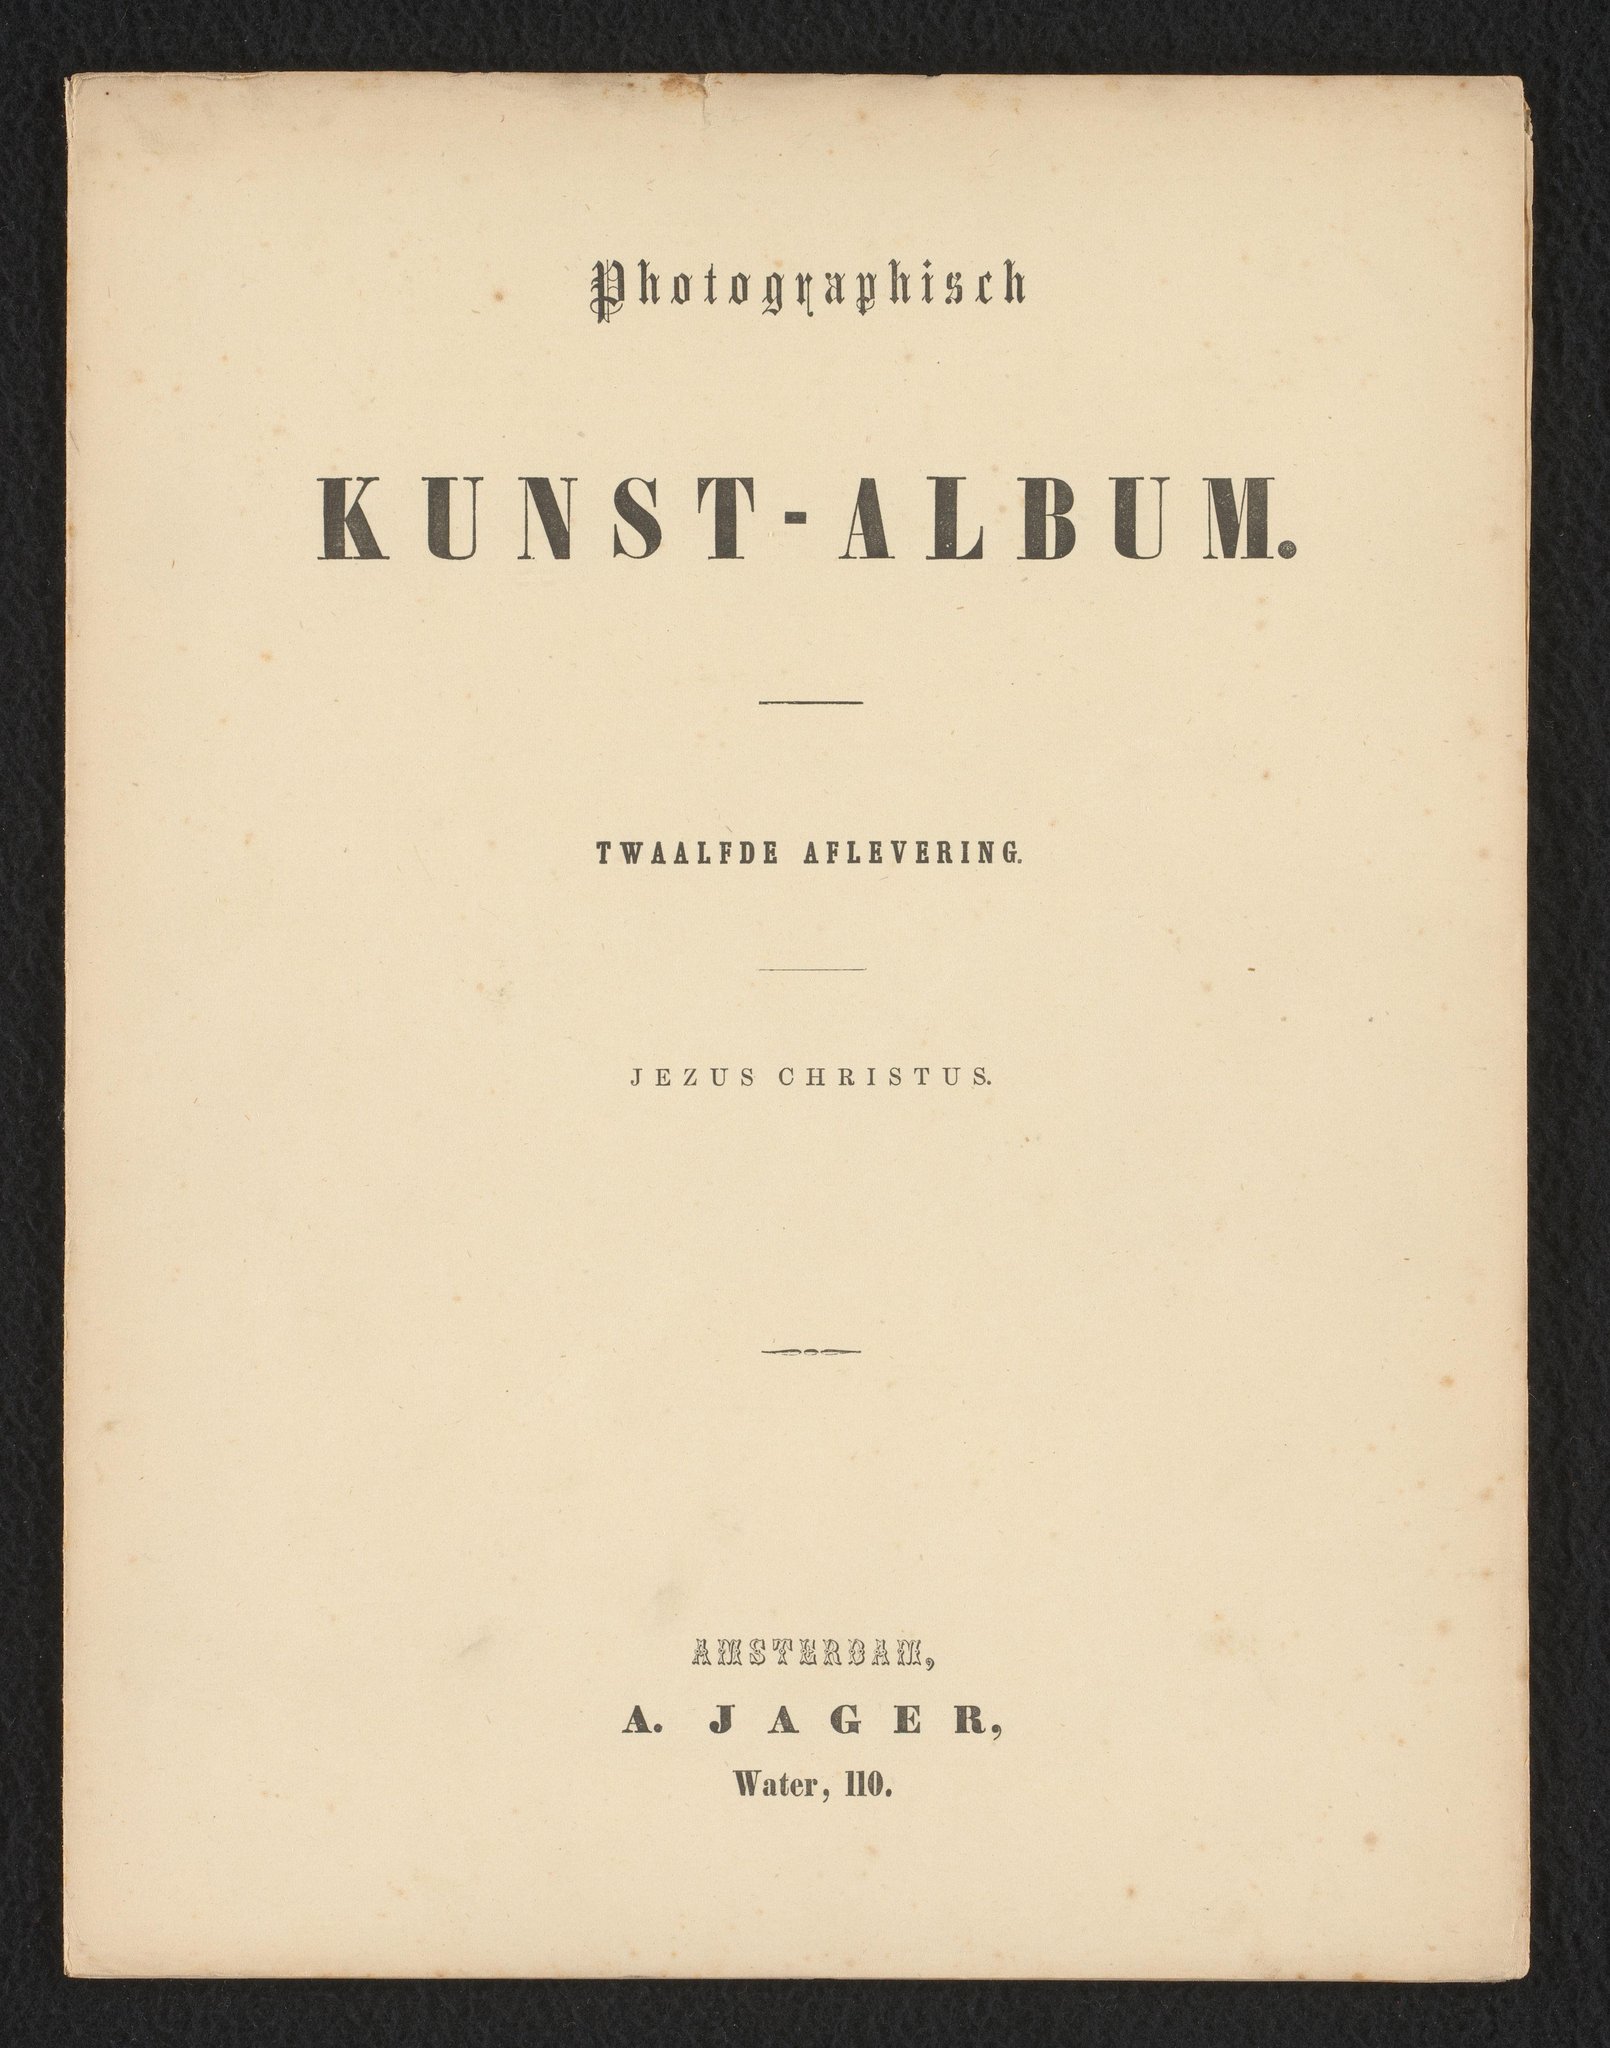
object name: wrapper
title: Twaalfde aflevering. Jezus Christus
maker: andries jager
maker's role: publisher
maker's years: 1825-1905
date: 1860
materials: paper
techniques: printing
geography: amsterdam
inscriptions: inscription: ‘JEZUS CHRISTUS/ NAAR EENE SCHILDERIJ/ VAN/ A. SCHEFFER.’, address: ‘AMSTERDAM,/ A. JAGER,/ Water, 110.’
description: Deze omslag maakt deel uit van een omslag met twaalf fotoreproducties.